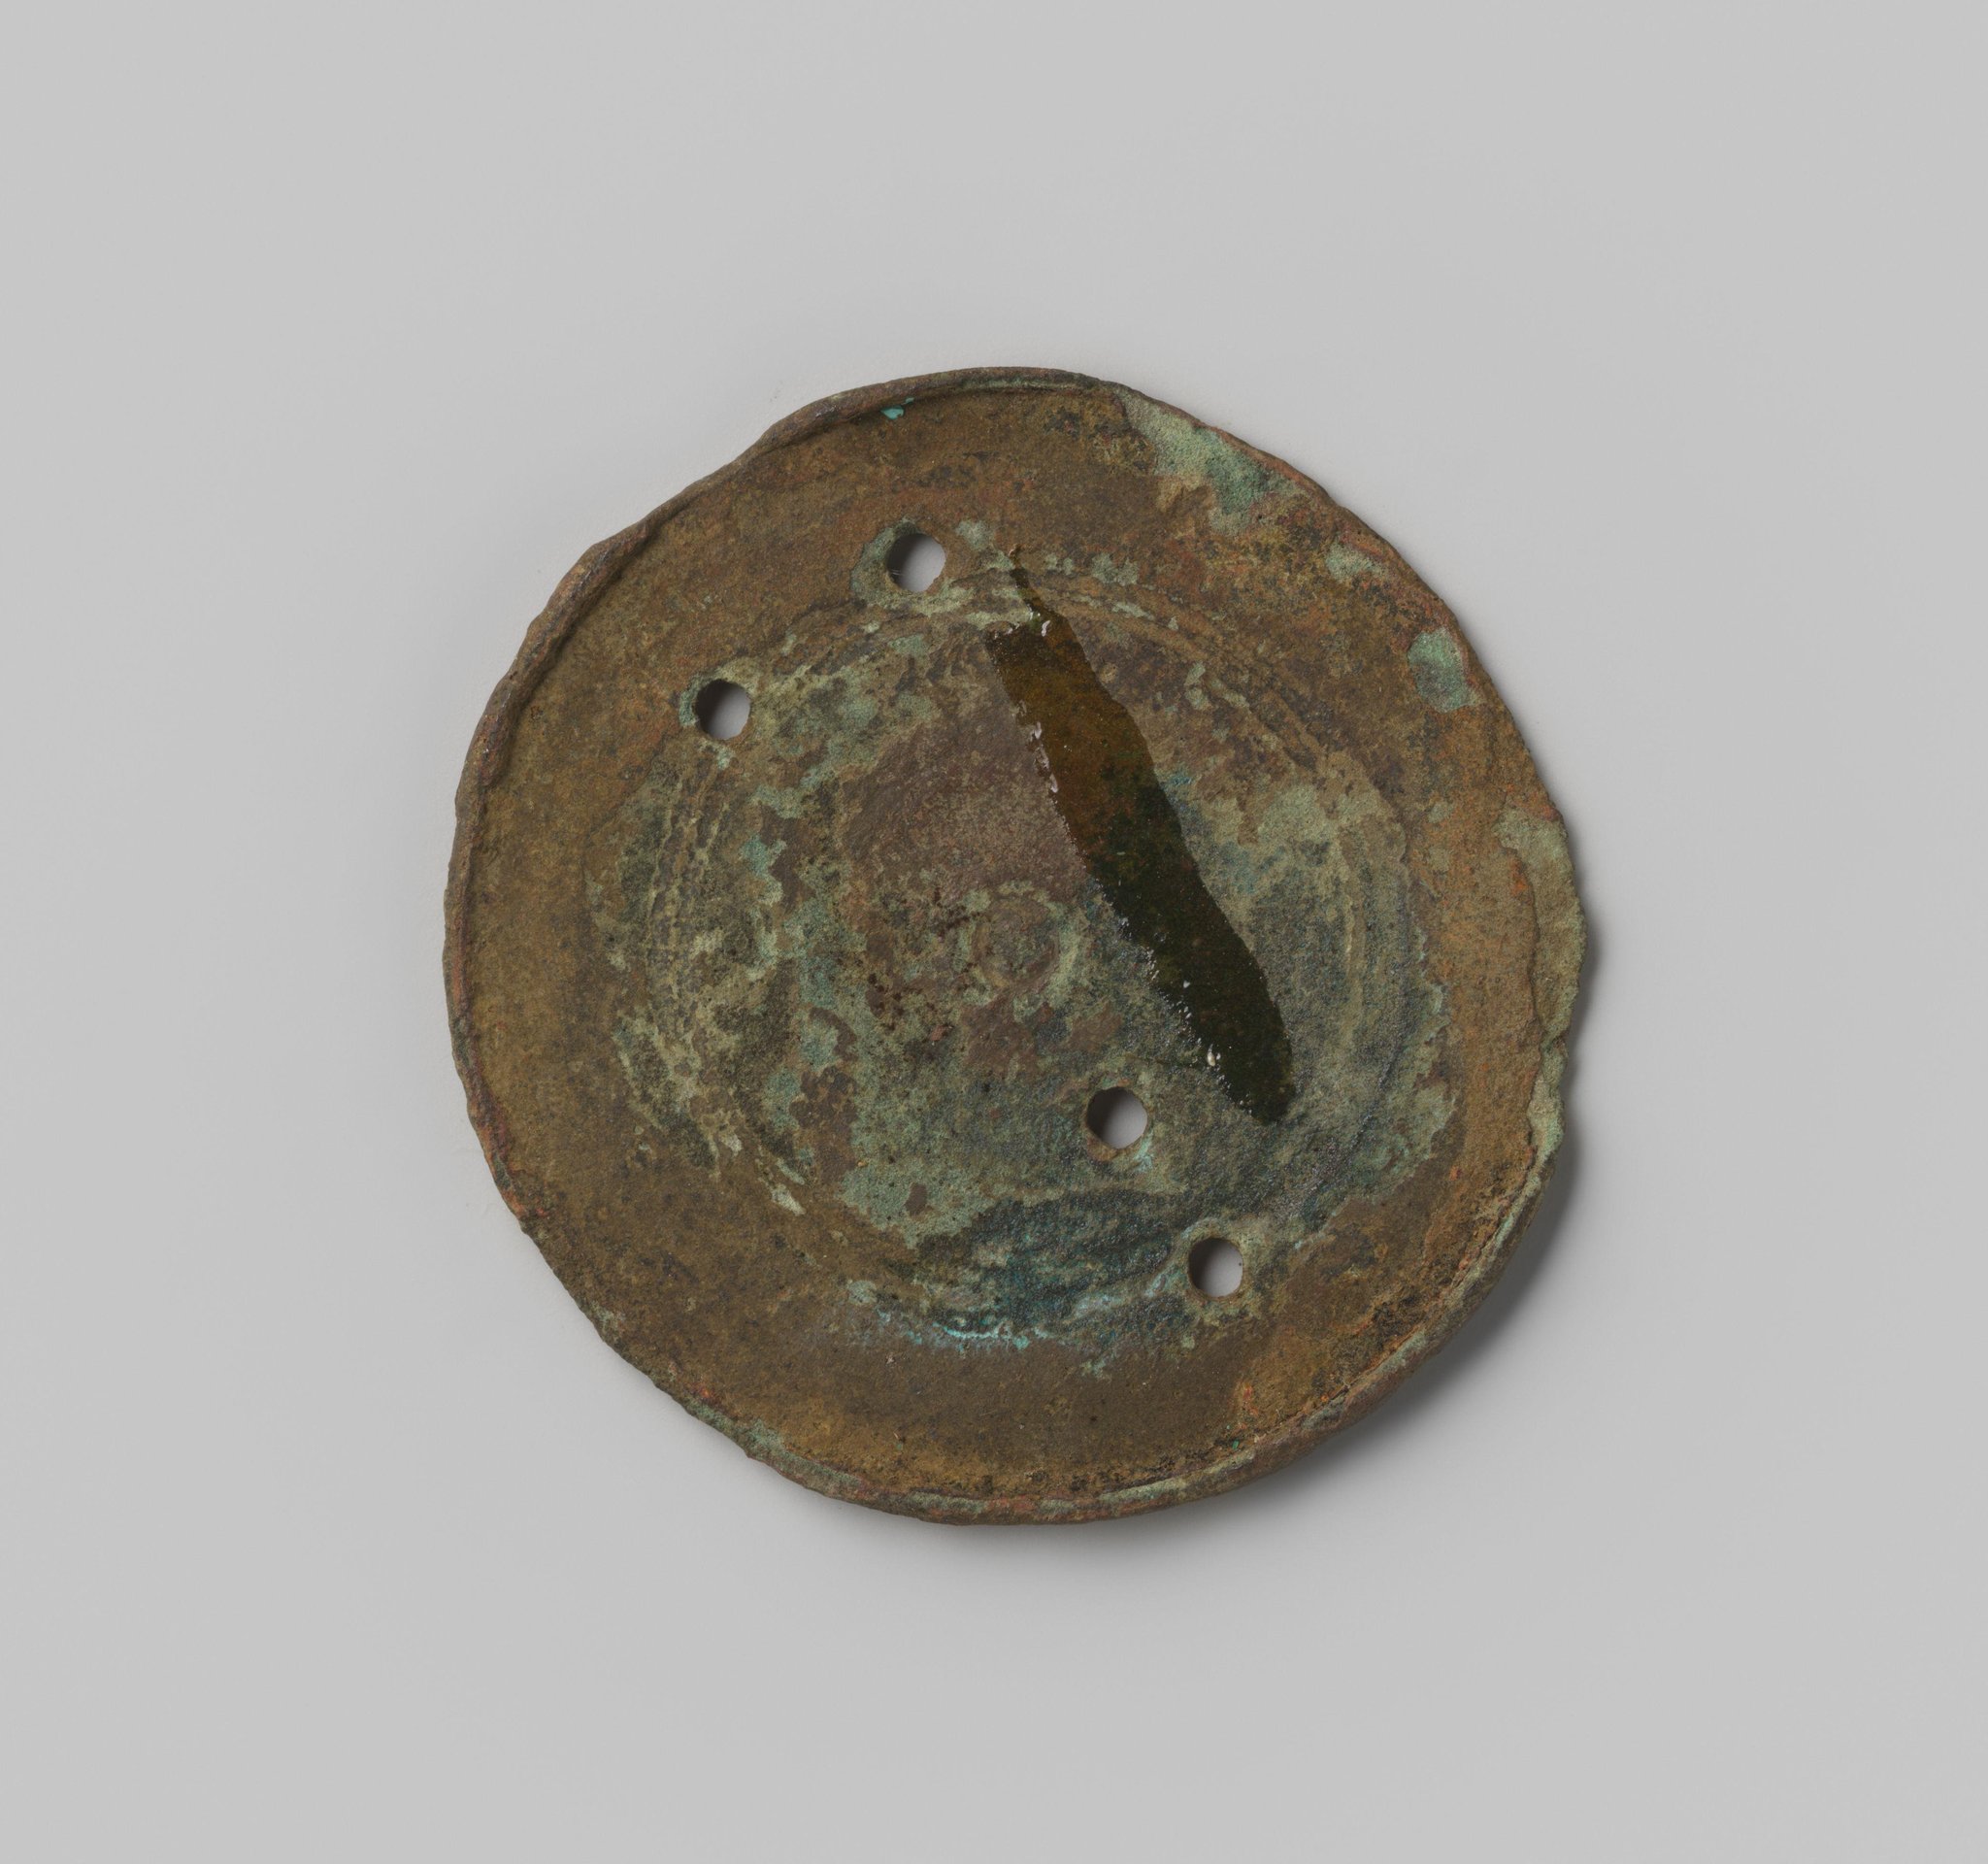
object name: sluitgewicht, pijlgewicht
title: Deksel van een sluitgewicht uit het wrak van de Oost-Indiëvaarder Hollandia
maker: Anonymous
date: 1700-1743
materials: copper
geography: netherlands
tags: verenigde oostindische compagnie, hollandia (schip), annet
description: Weight, cupweight, lid; id. NG 1980-27H33, eroded, 1 mark id. NG 1980-27H2892 legible.